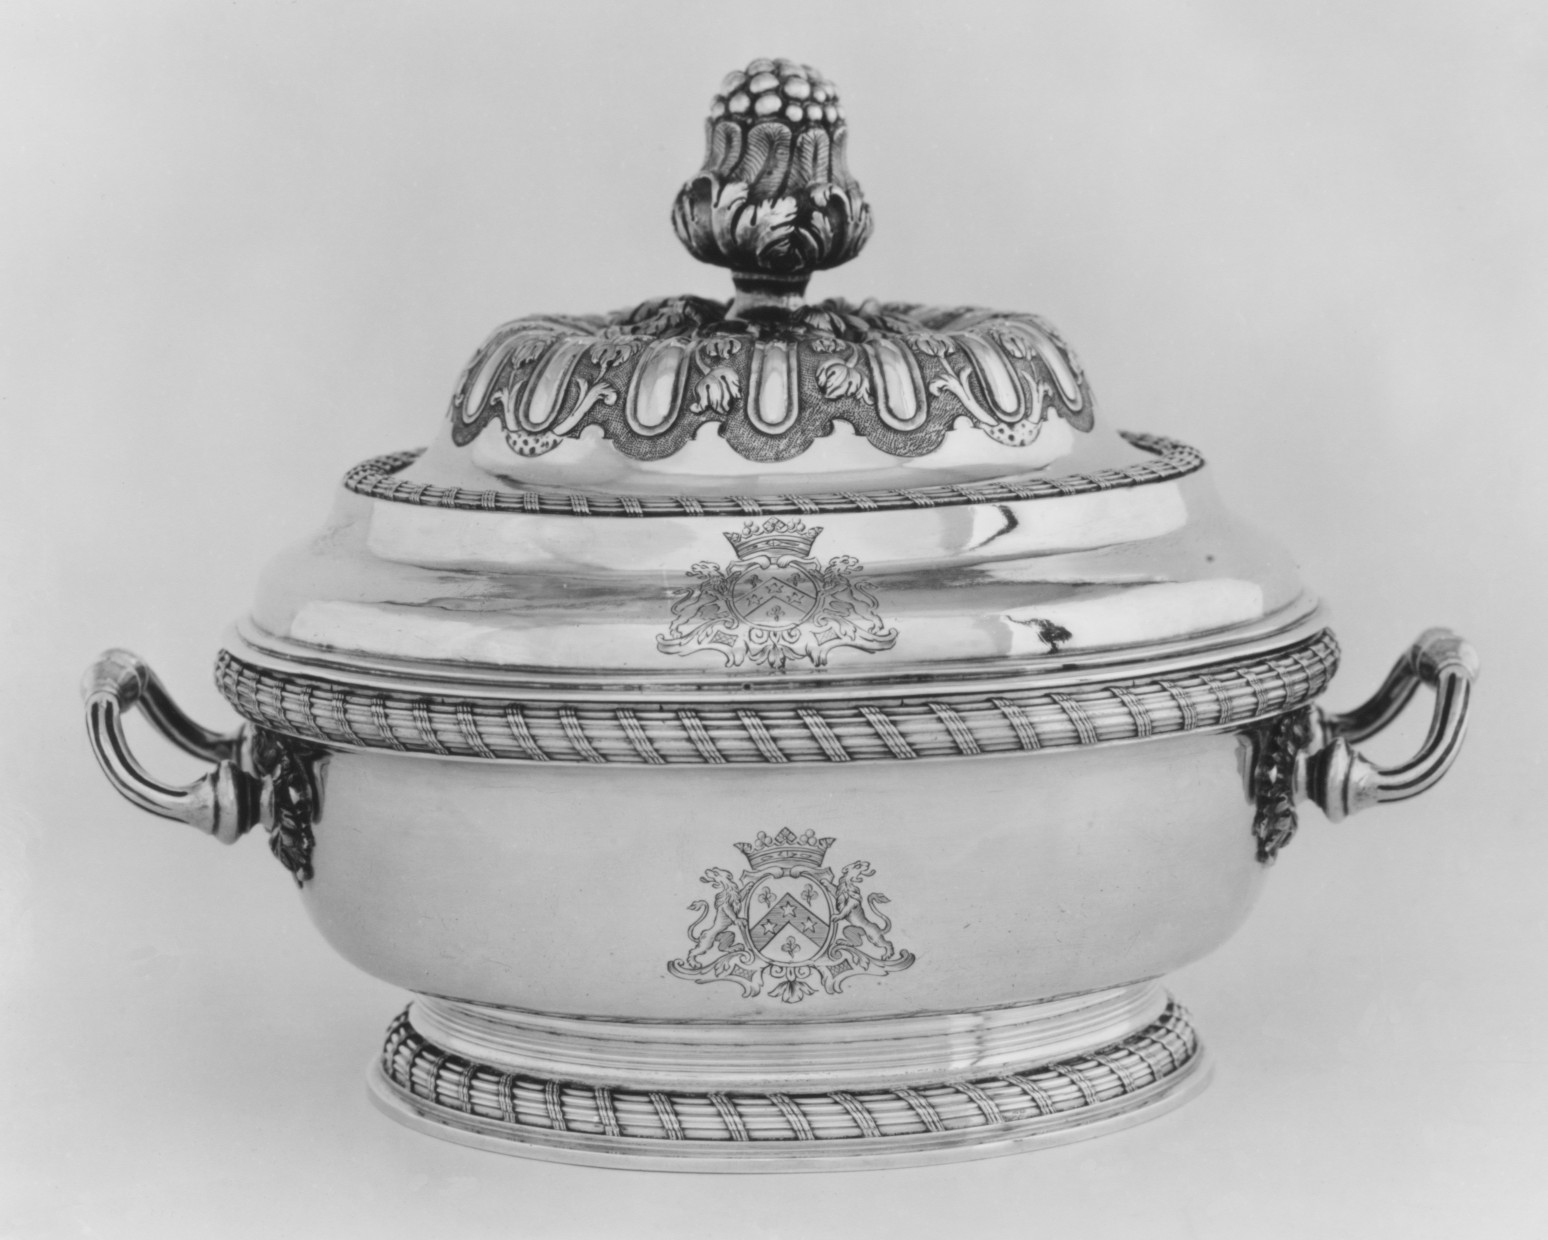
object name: tureen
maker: jean-louis bertrand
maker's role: maker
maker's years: 1718-1778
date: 1748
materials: silver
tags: coat of arms